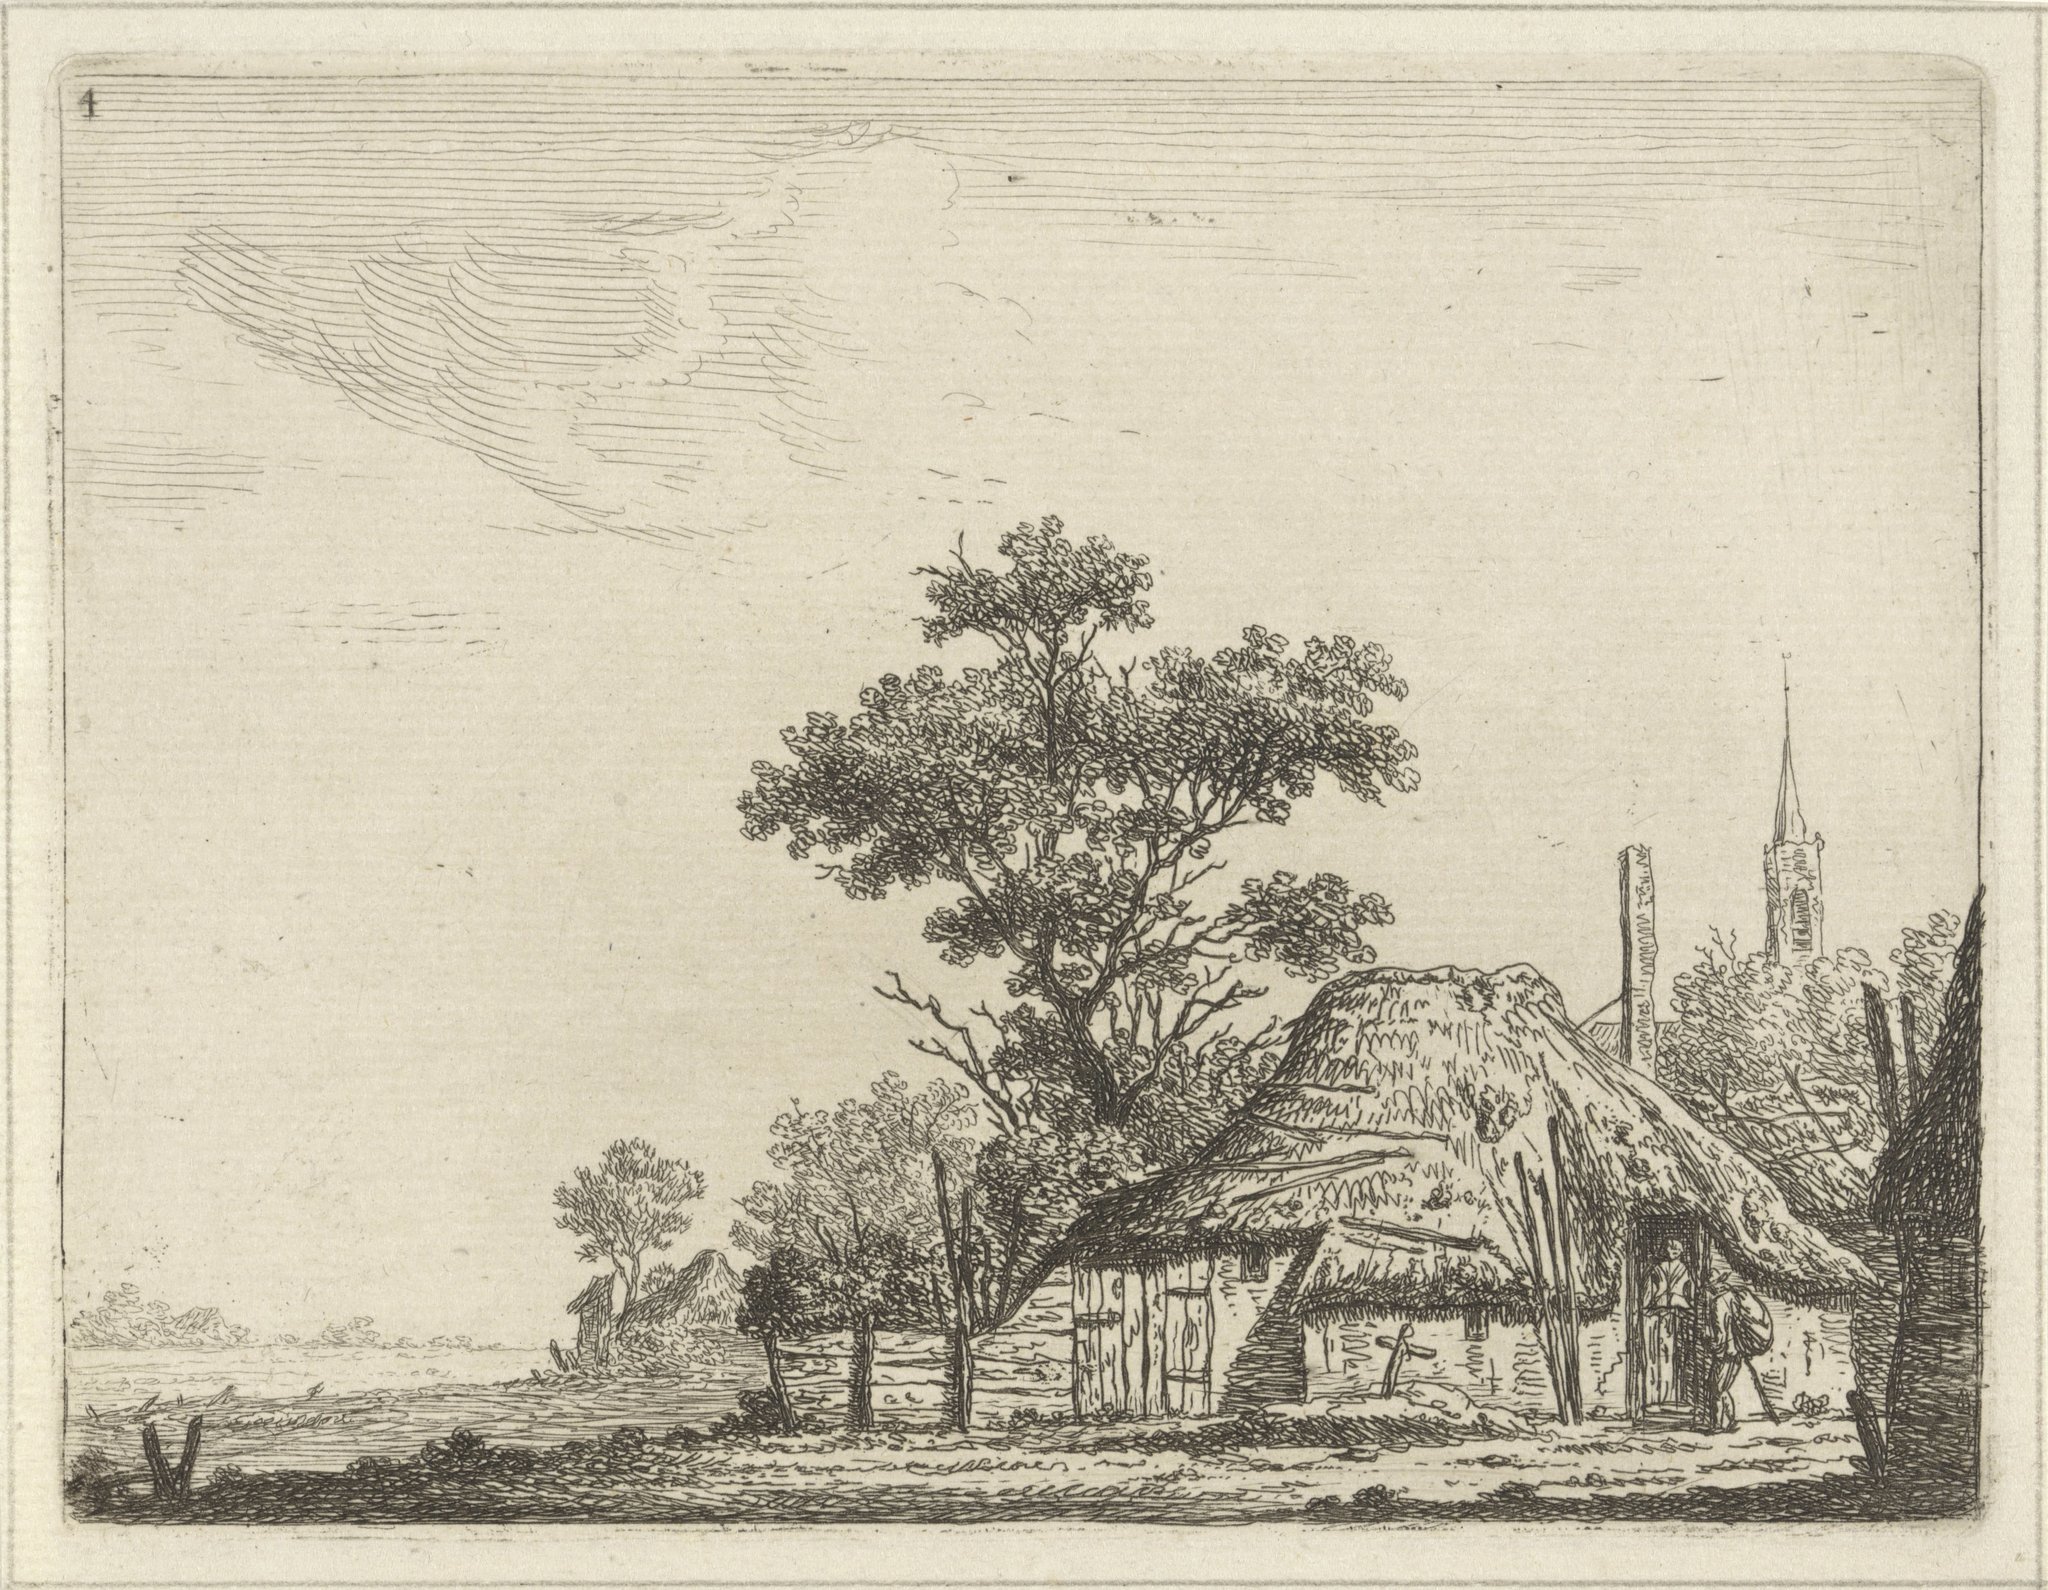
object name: print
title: Boerderij met op de achtergrond een kerk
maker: hendrik schwegman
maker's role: draughtsman, print maker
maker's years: 1761-1816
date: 1786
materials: paper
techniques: engraving, etching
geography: haarlem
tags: farm or solitary house in landscape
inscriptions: collector's mark: Lugt 2228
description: Landschap met een boerderij met strooien dak. In de deur staat een vrouw te praten met een voorbijganger. Rechts achter een kerktoren. Links weilanden en een vaart.